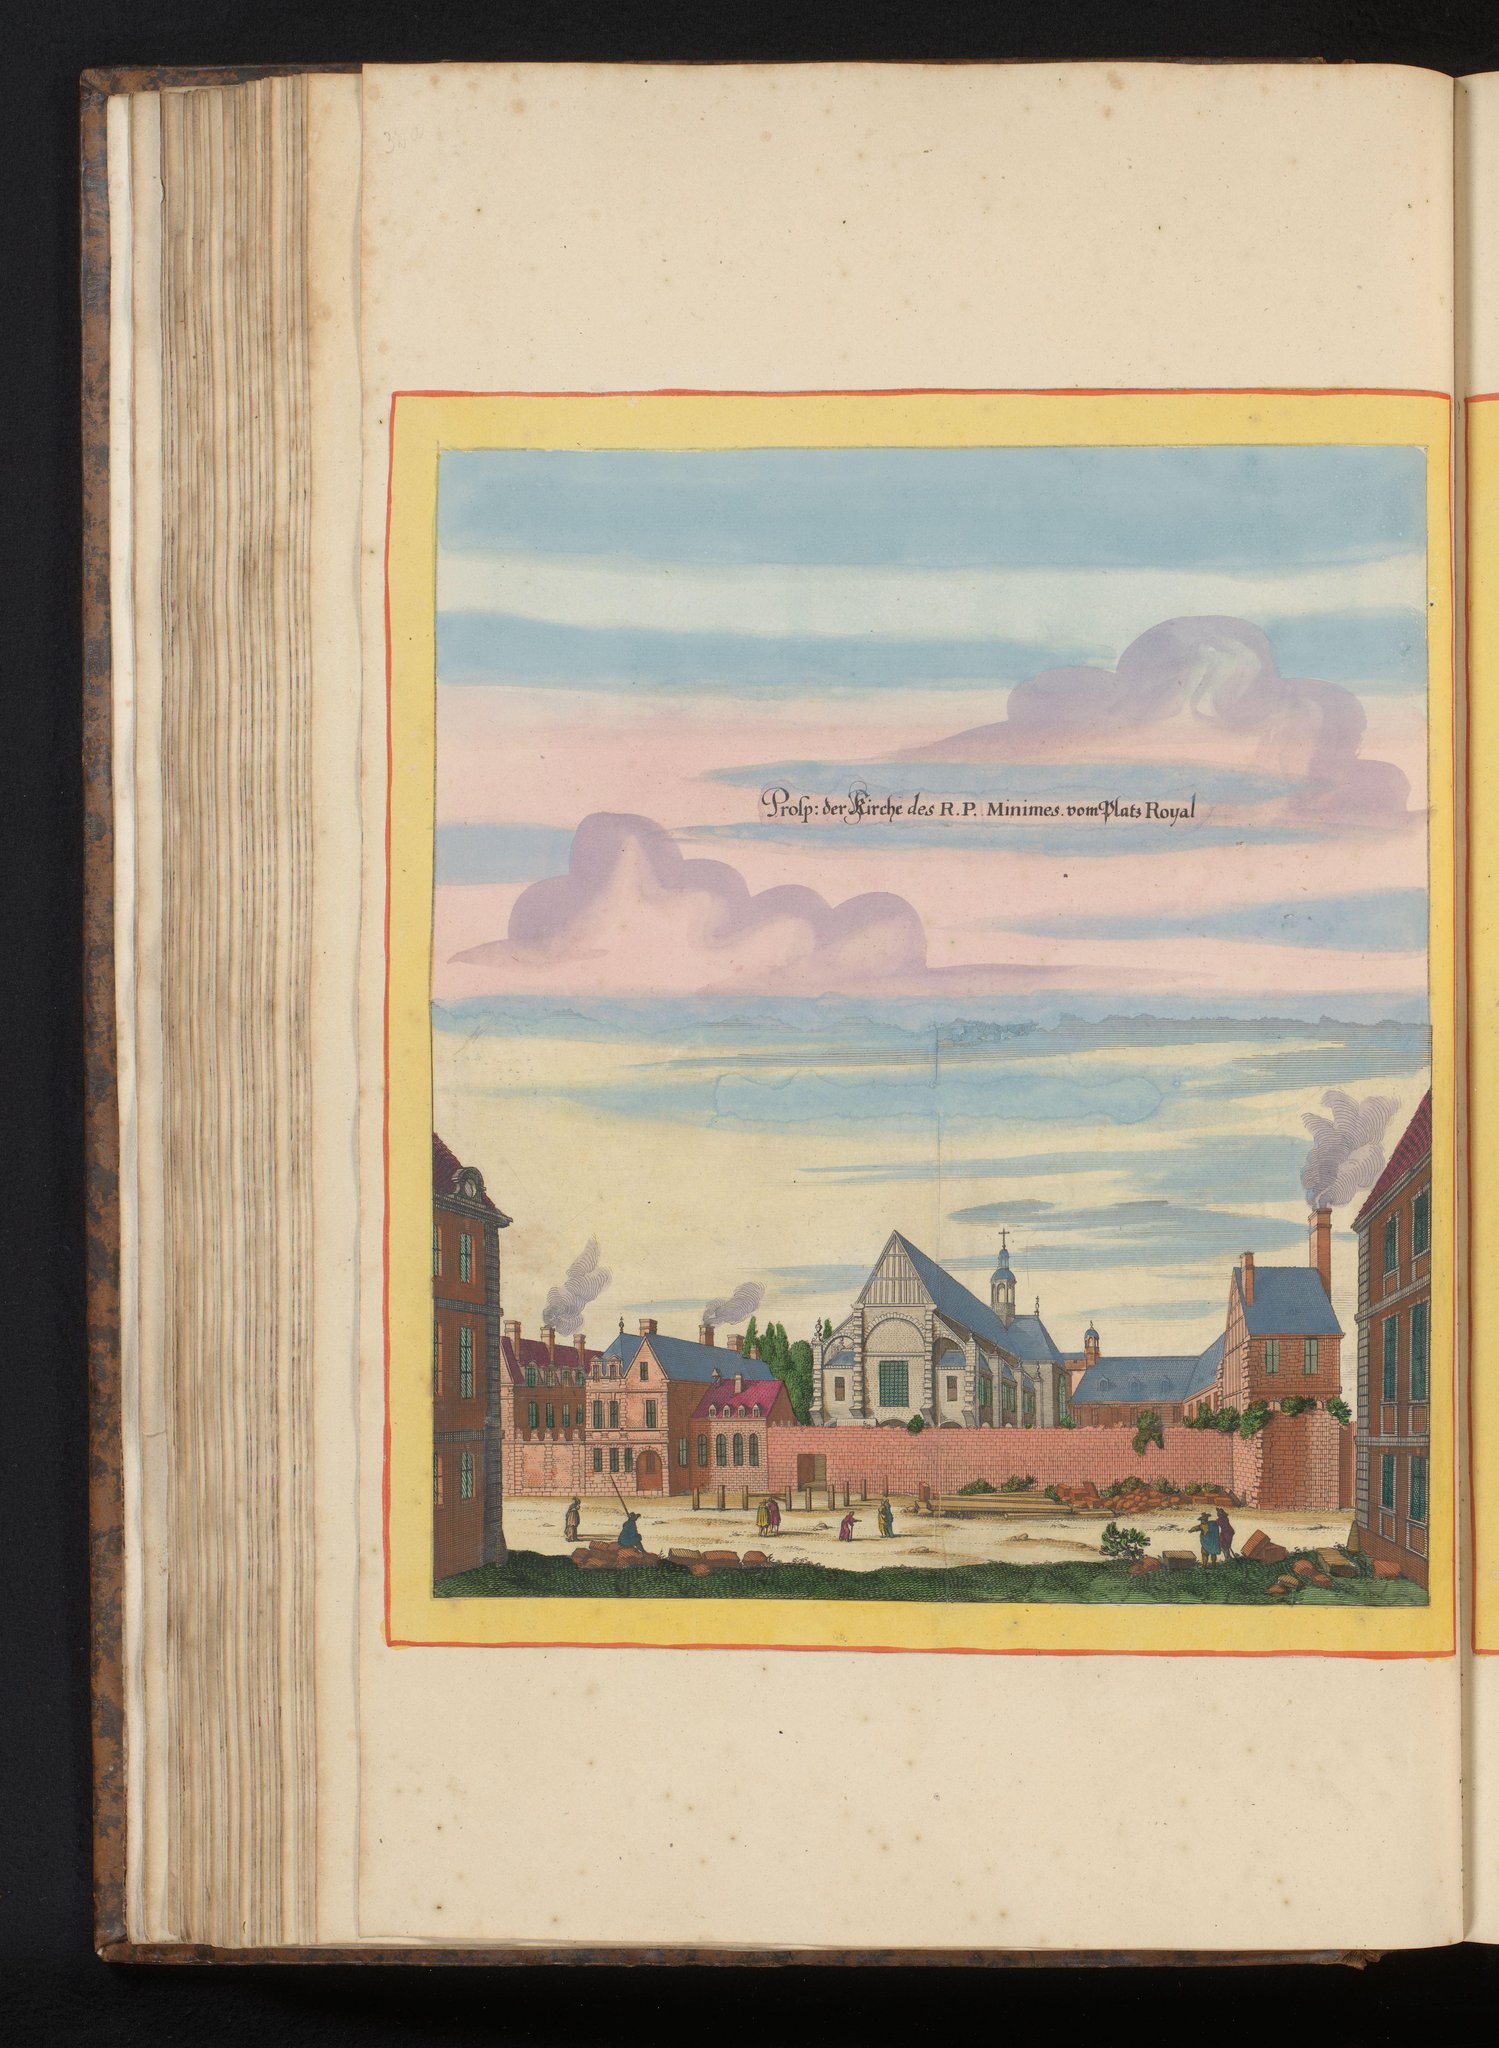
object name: print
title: Gezicht op het klooster en de kerk van de Orde van de Miniemen te Parijs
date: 1655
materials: paper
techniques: engraving, etching, hand coloring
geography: paris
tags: abbey, monastery, convent ~ roman catholic church, church (exterior)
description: Prent origineel vervaardigd als boekillustratie voor: Zeiller, Martin. Topographia Galliae, oder Beschreibung und Contrafaitung der vornehmbsten und bekantisten Oerter in dem mächtigen und grossen Königreich Frankreich, 13 delen. Frankfurt am Main: Caspar Merian, 1655-1661. De prent werd voor het eerst gepubliceerd in deel 1: Topographia Galliae, 1655.